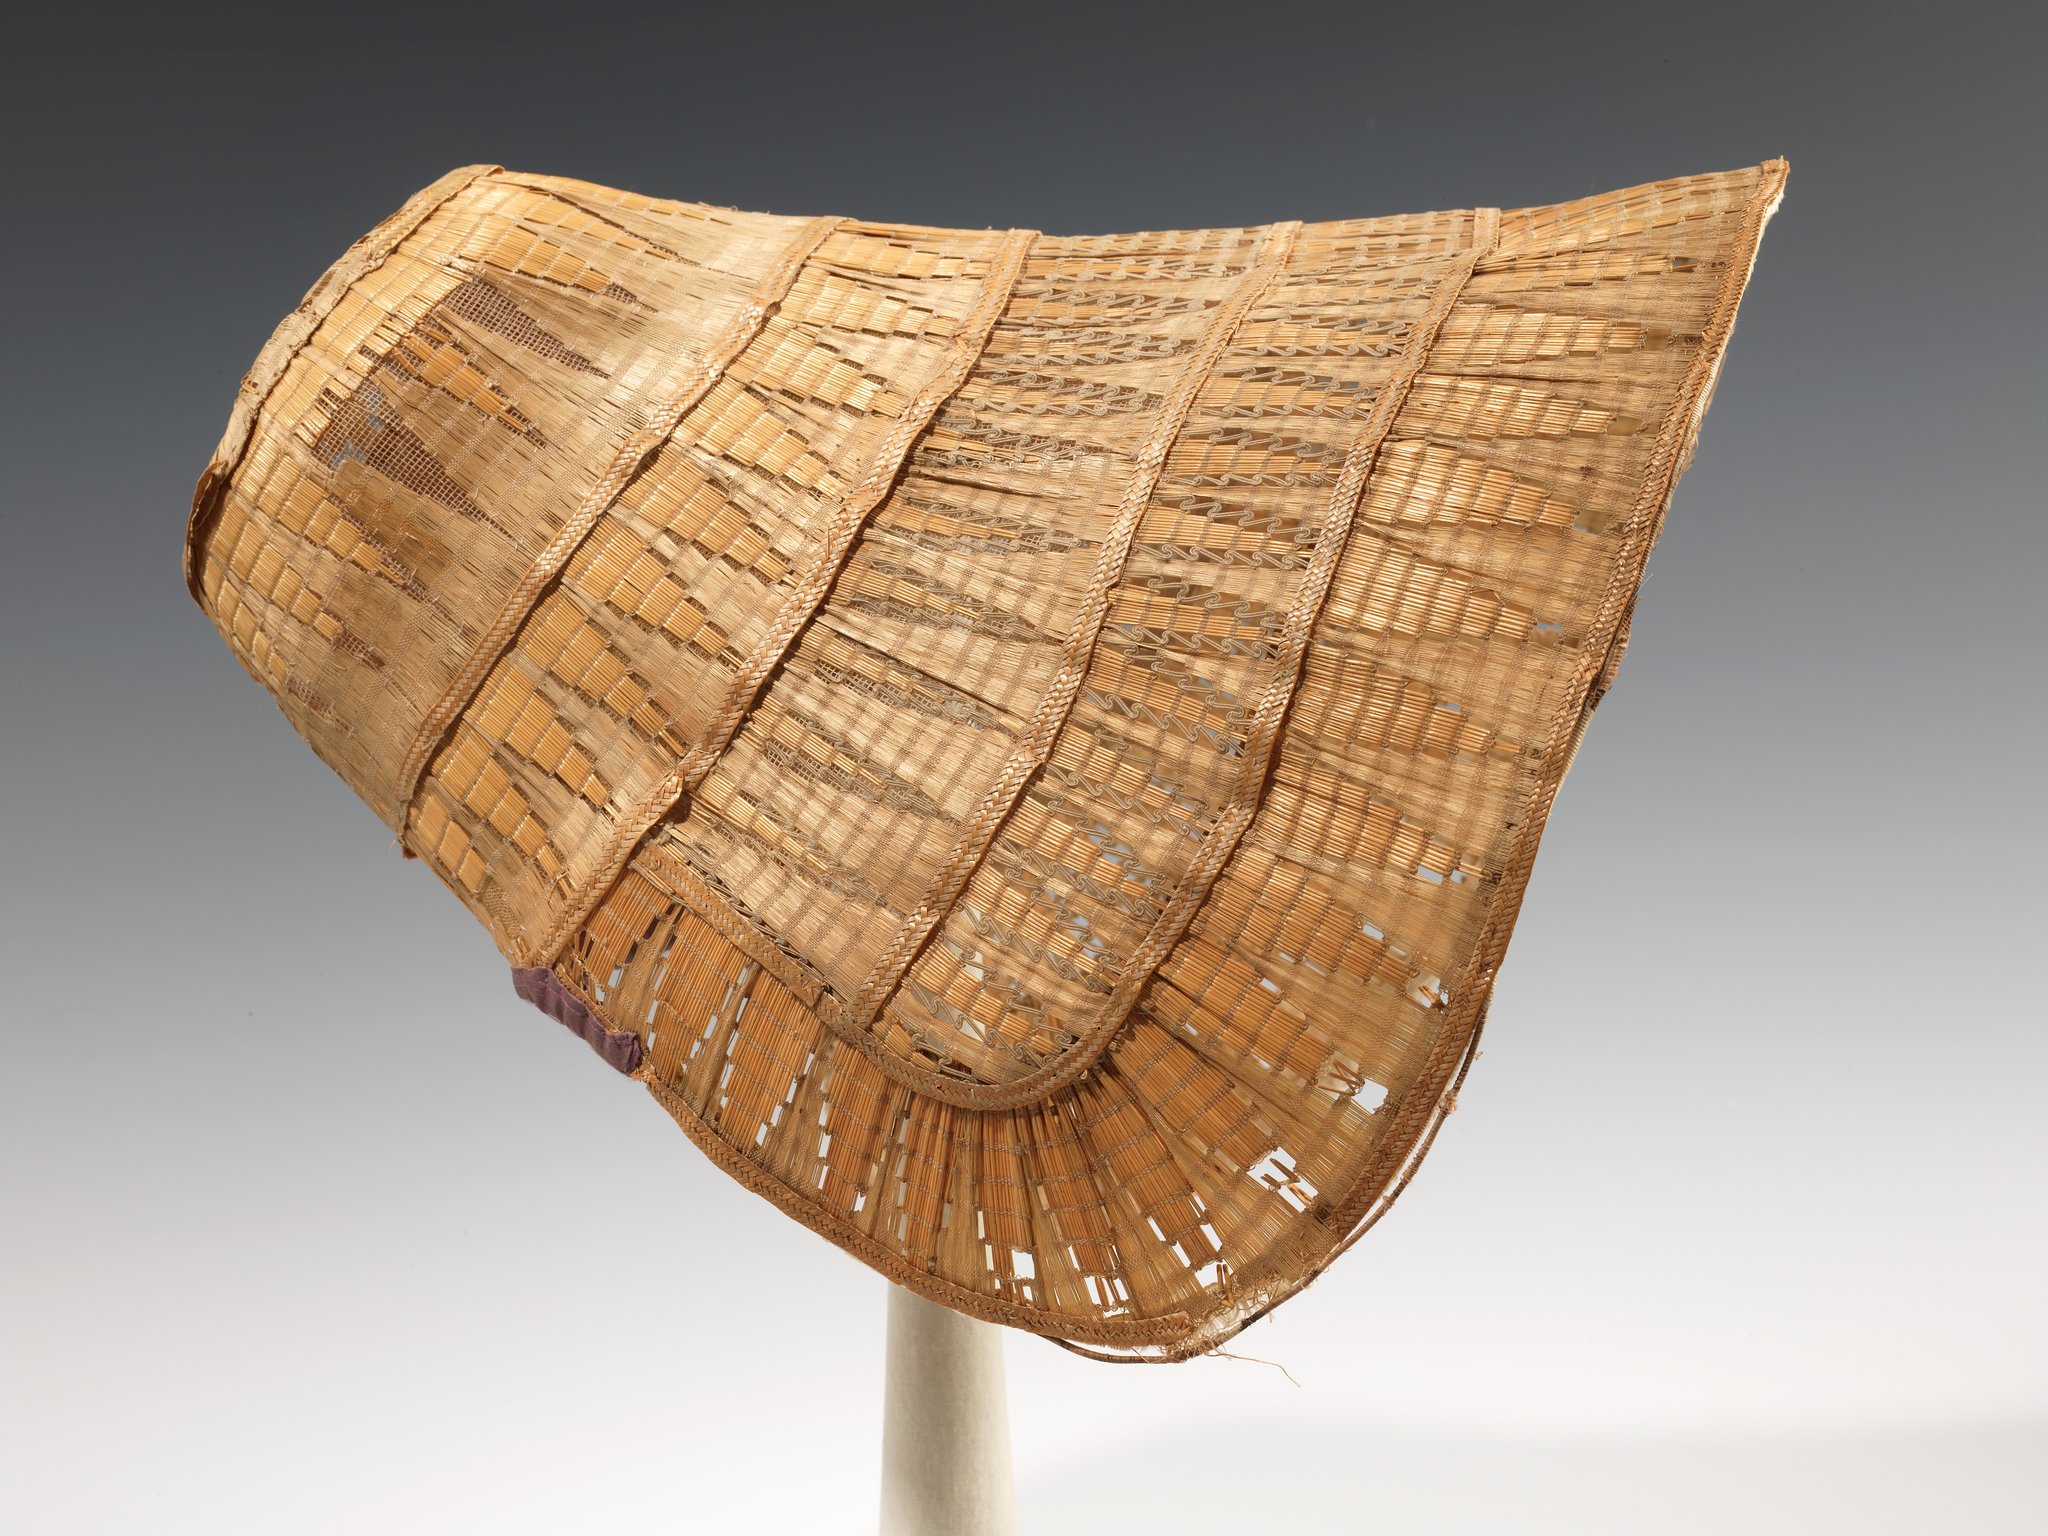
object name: poke bonnet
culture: american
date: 1835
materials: silk, fiber